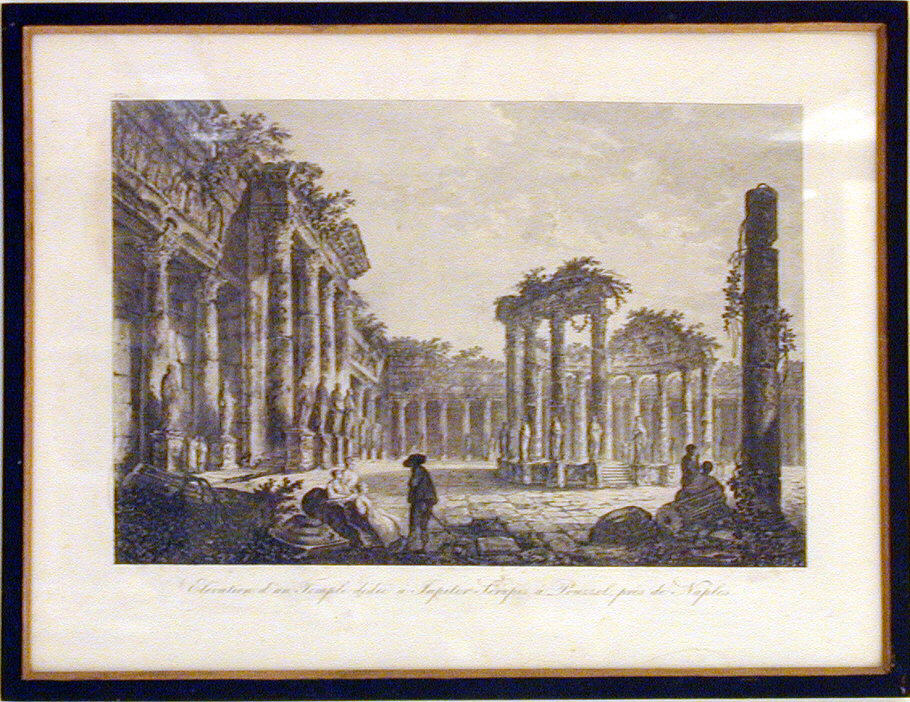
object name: engraving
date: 1701-1800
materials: ink, paper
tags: ruins,maps